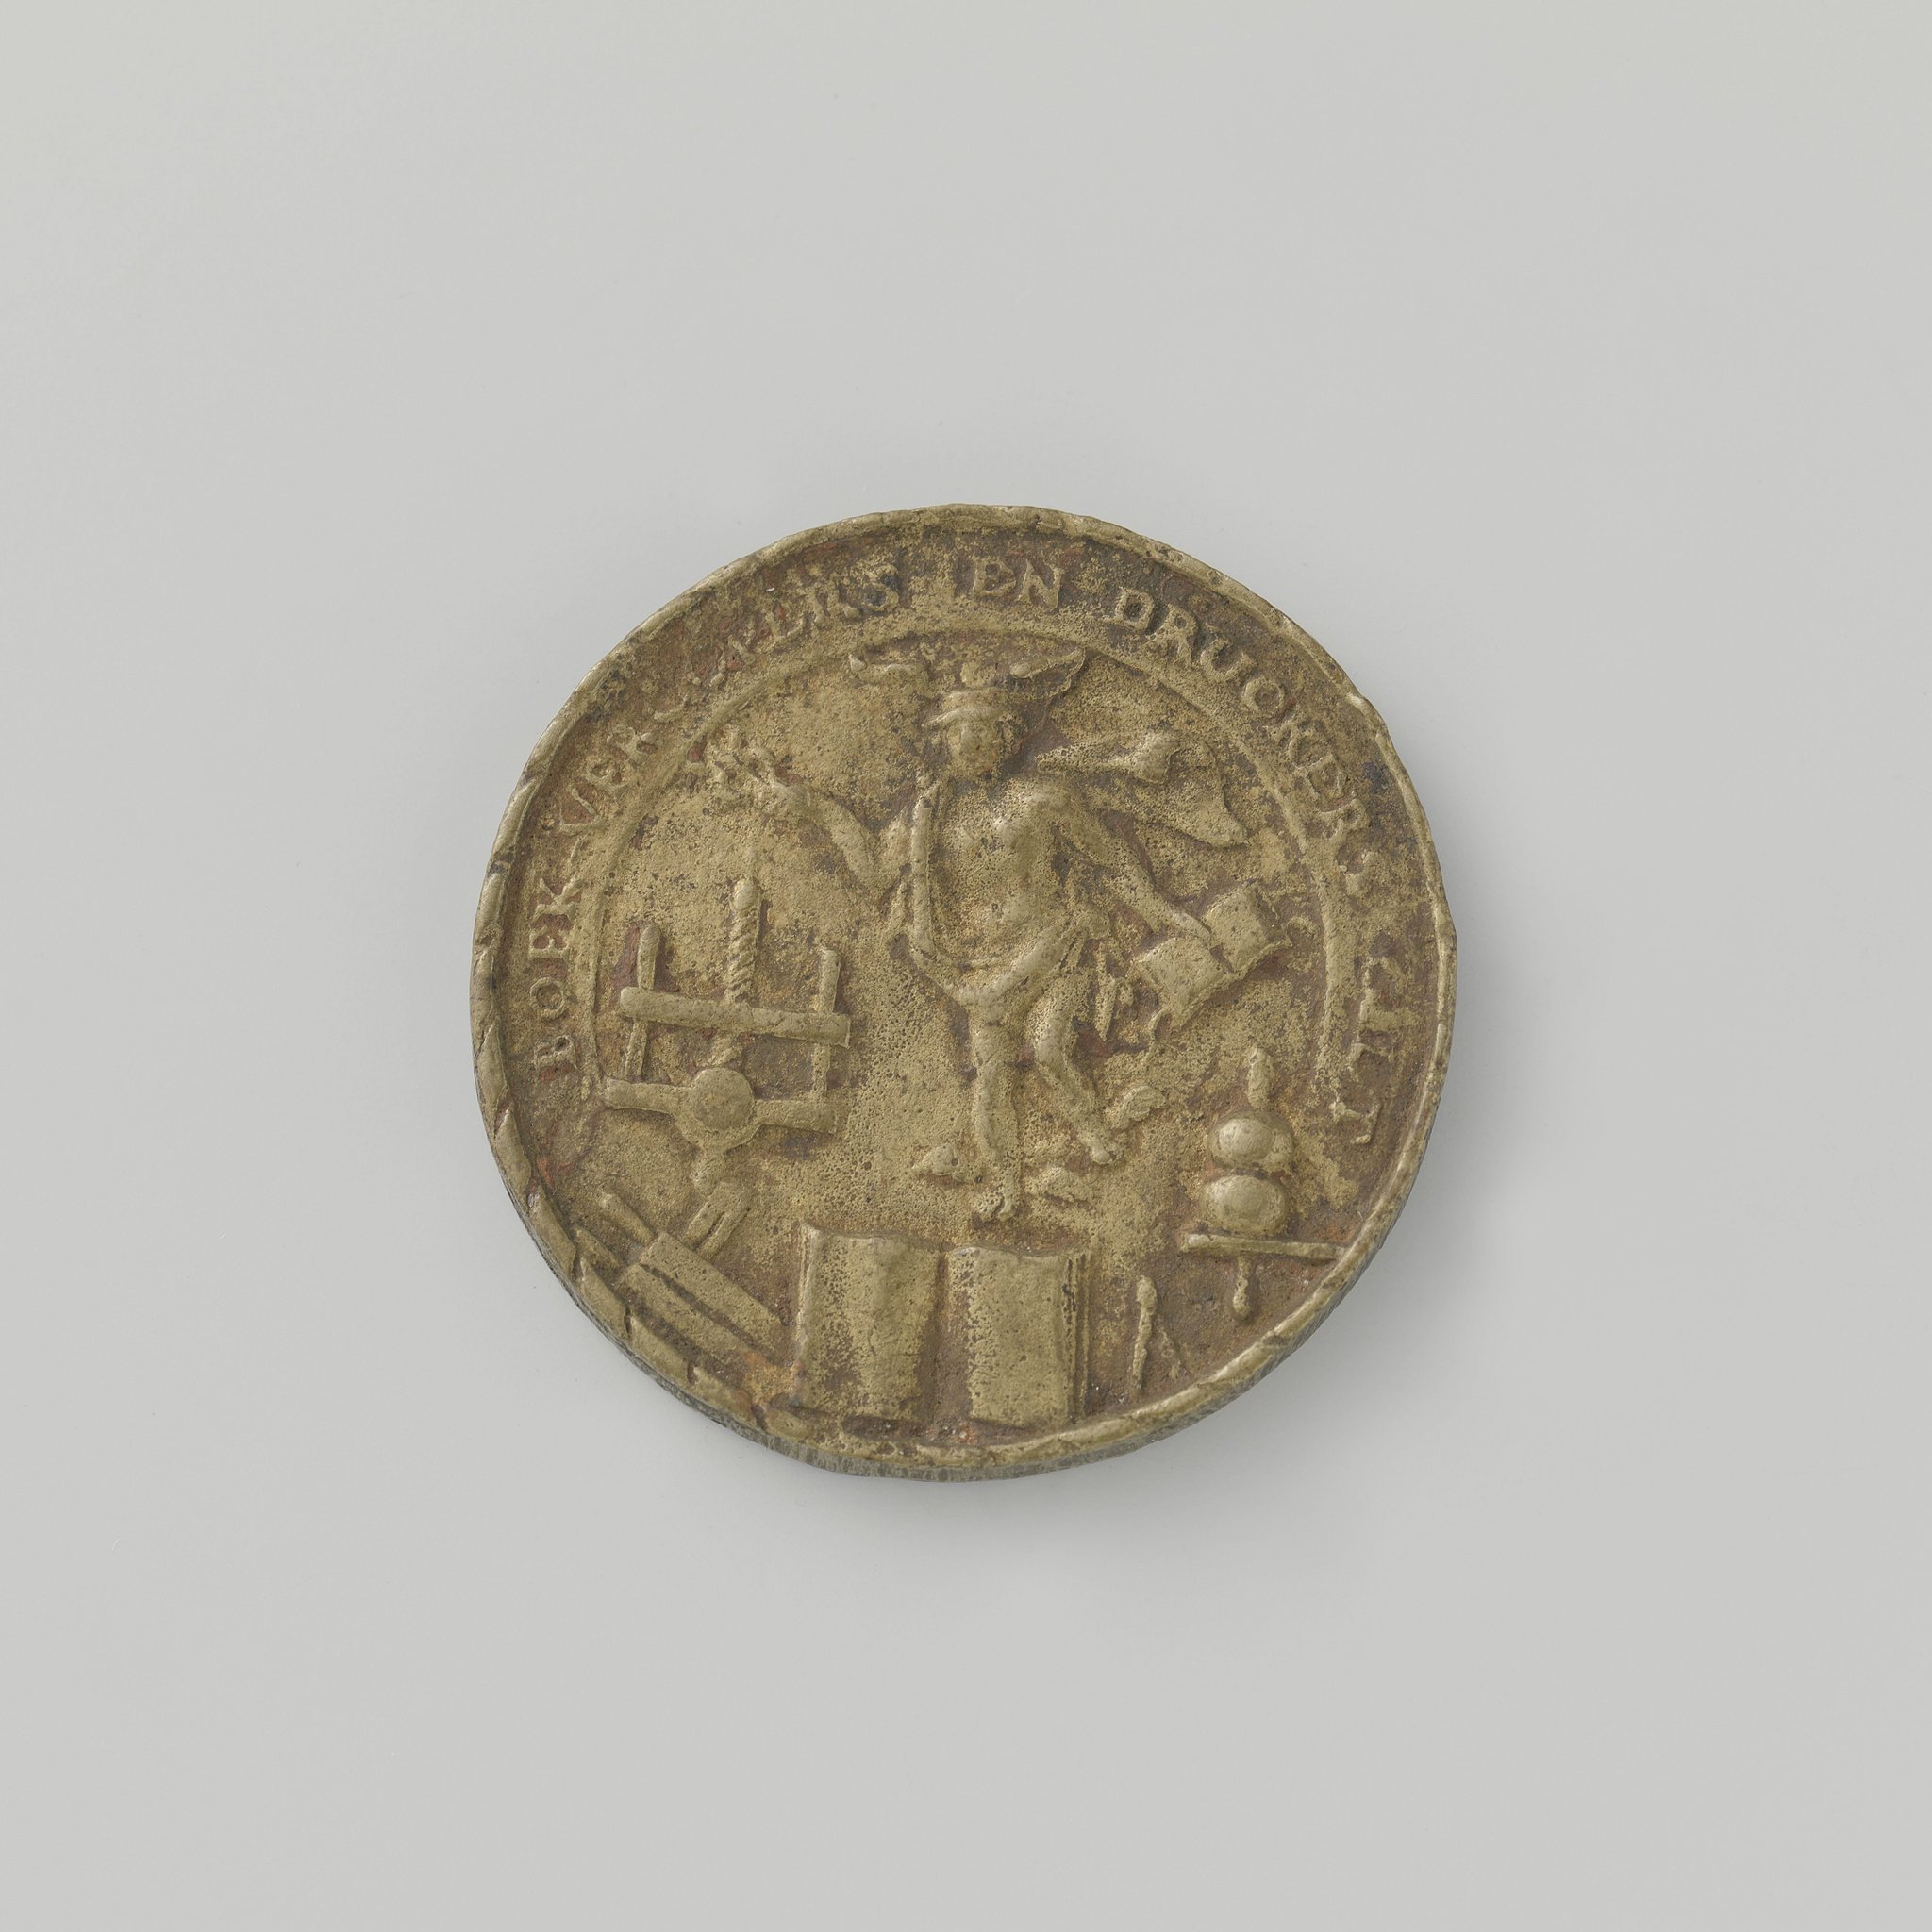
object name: medal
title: Booksellers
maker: Anonymous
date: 1685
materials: brass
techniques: casting, engraving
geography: amsterdam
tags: amsterdam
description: Guild medals Members of trade guilds had to identify themselves with a medal at their meetings.